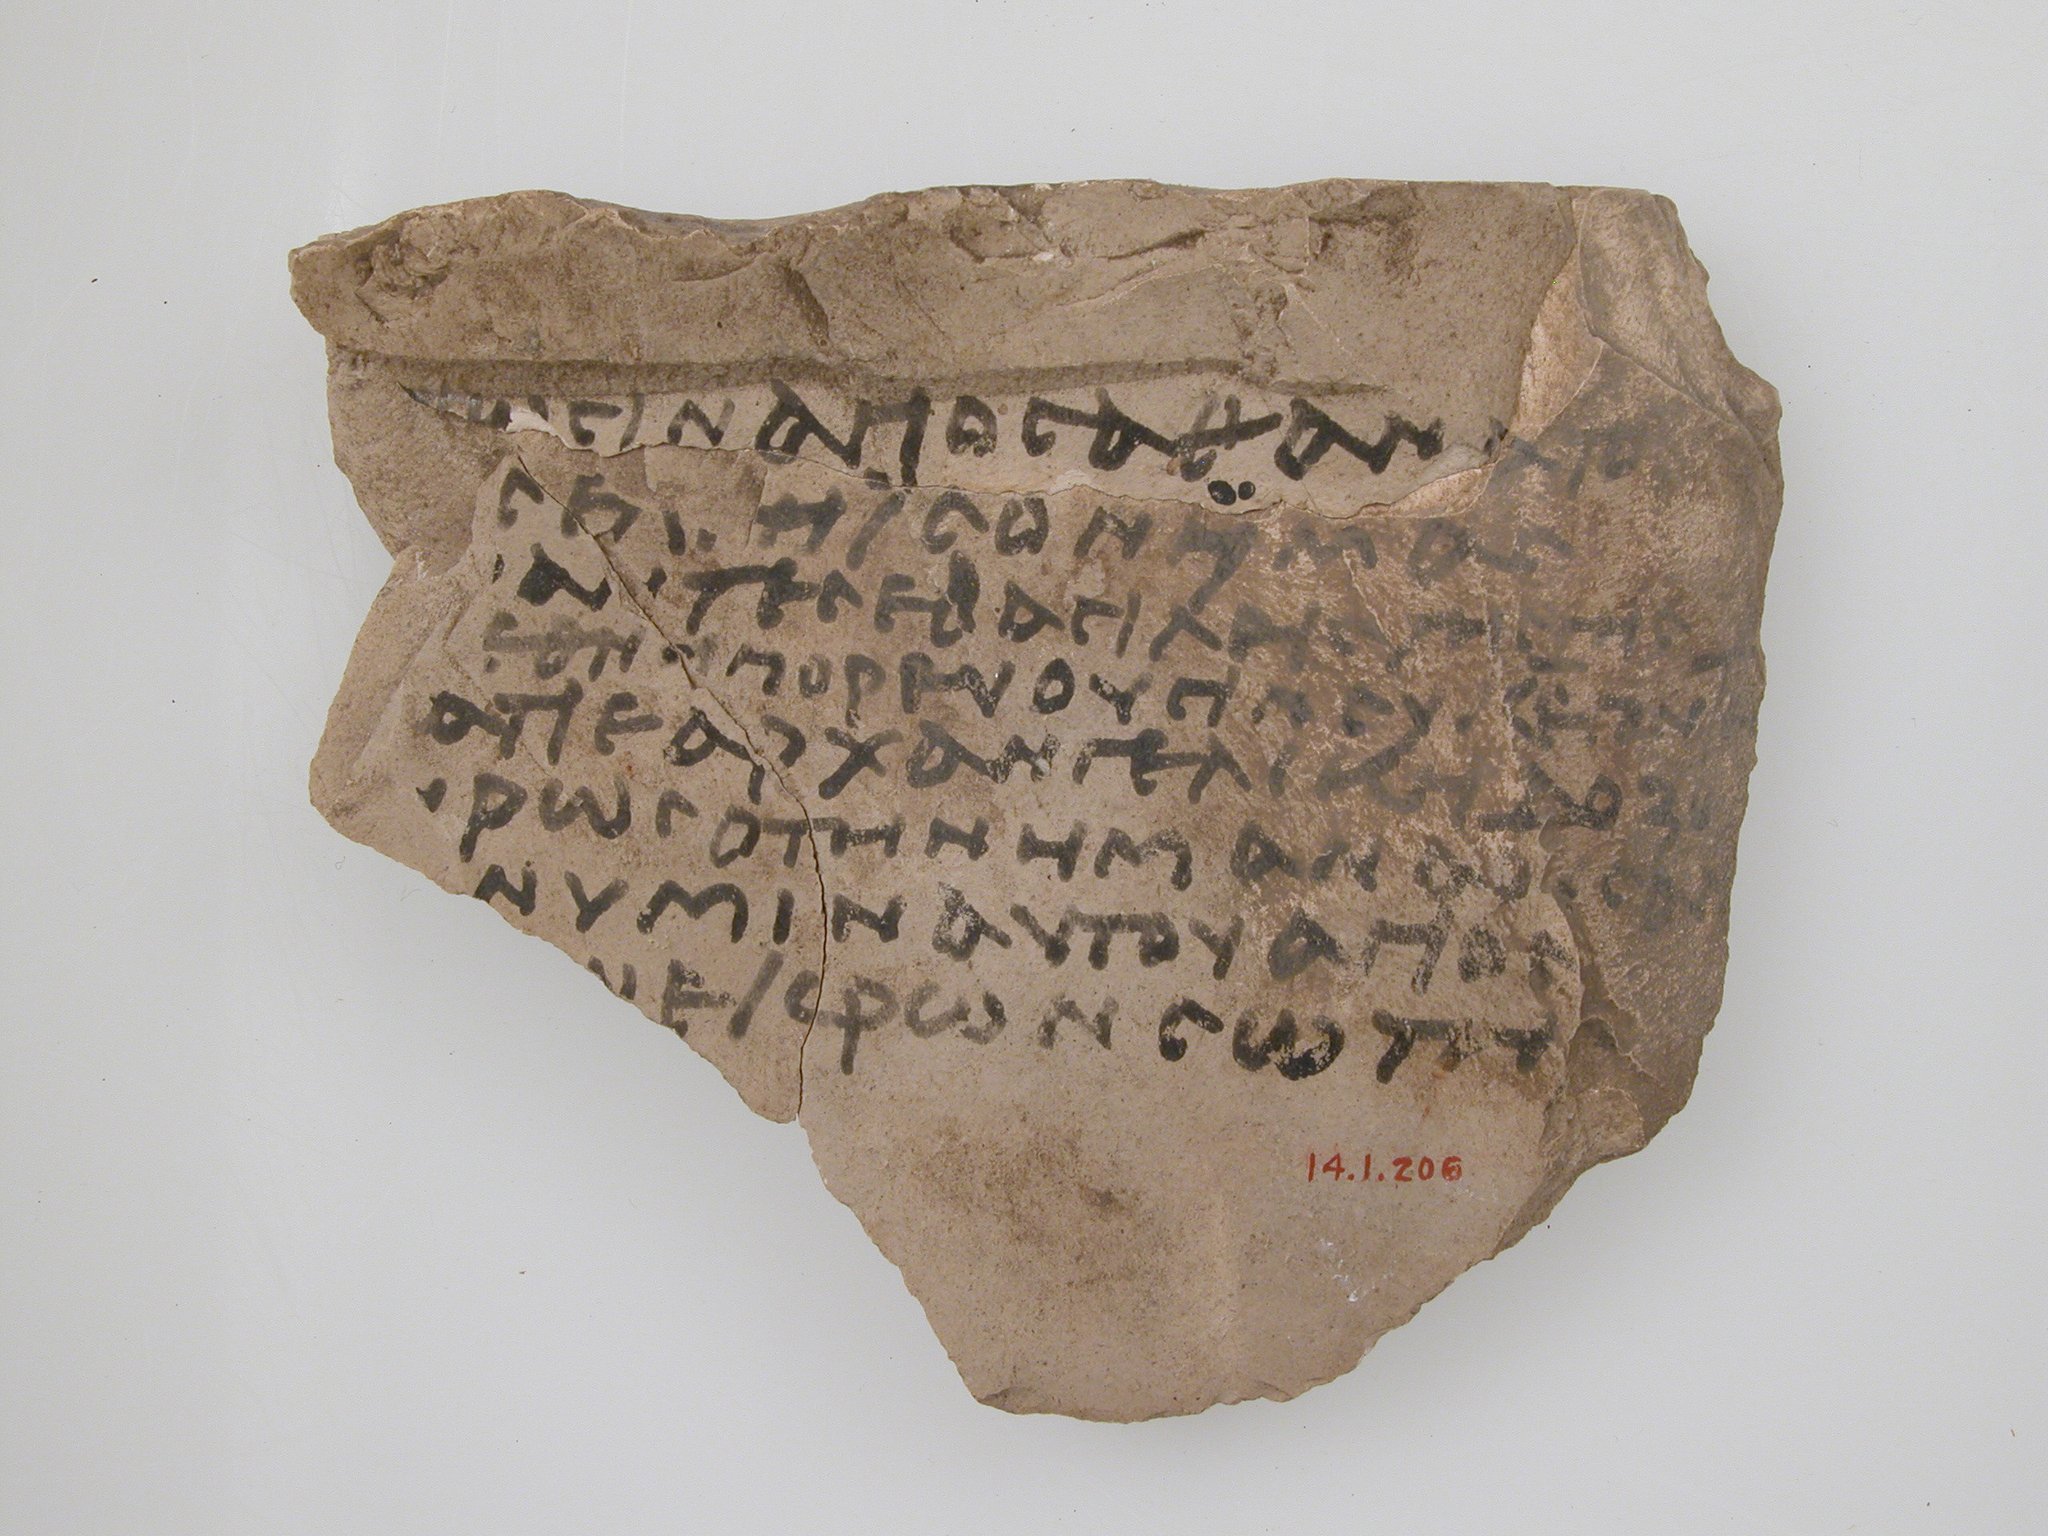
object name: ostrakon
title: Ostrakon with Trisagion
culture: coptic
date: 580-640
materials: ink, limestone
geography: egypt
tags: documents